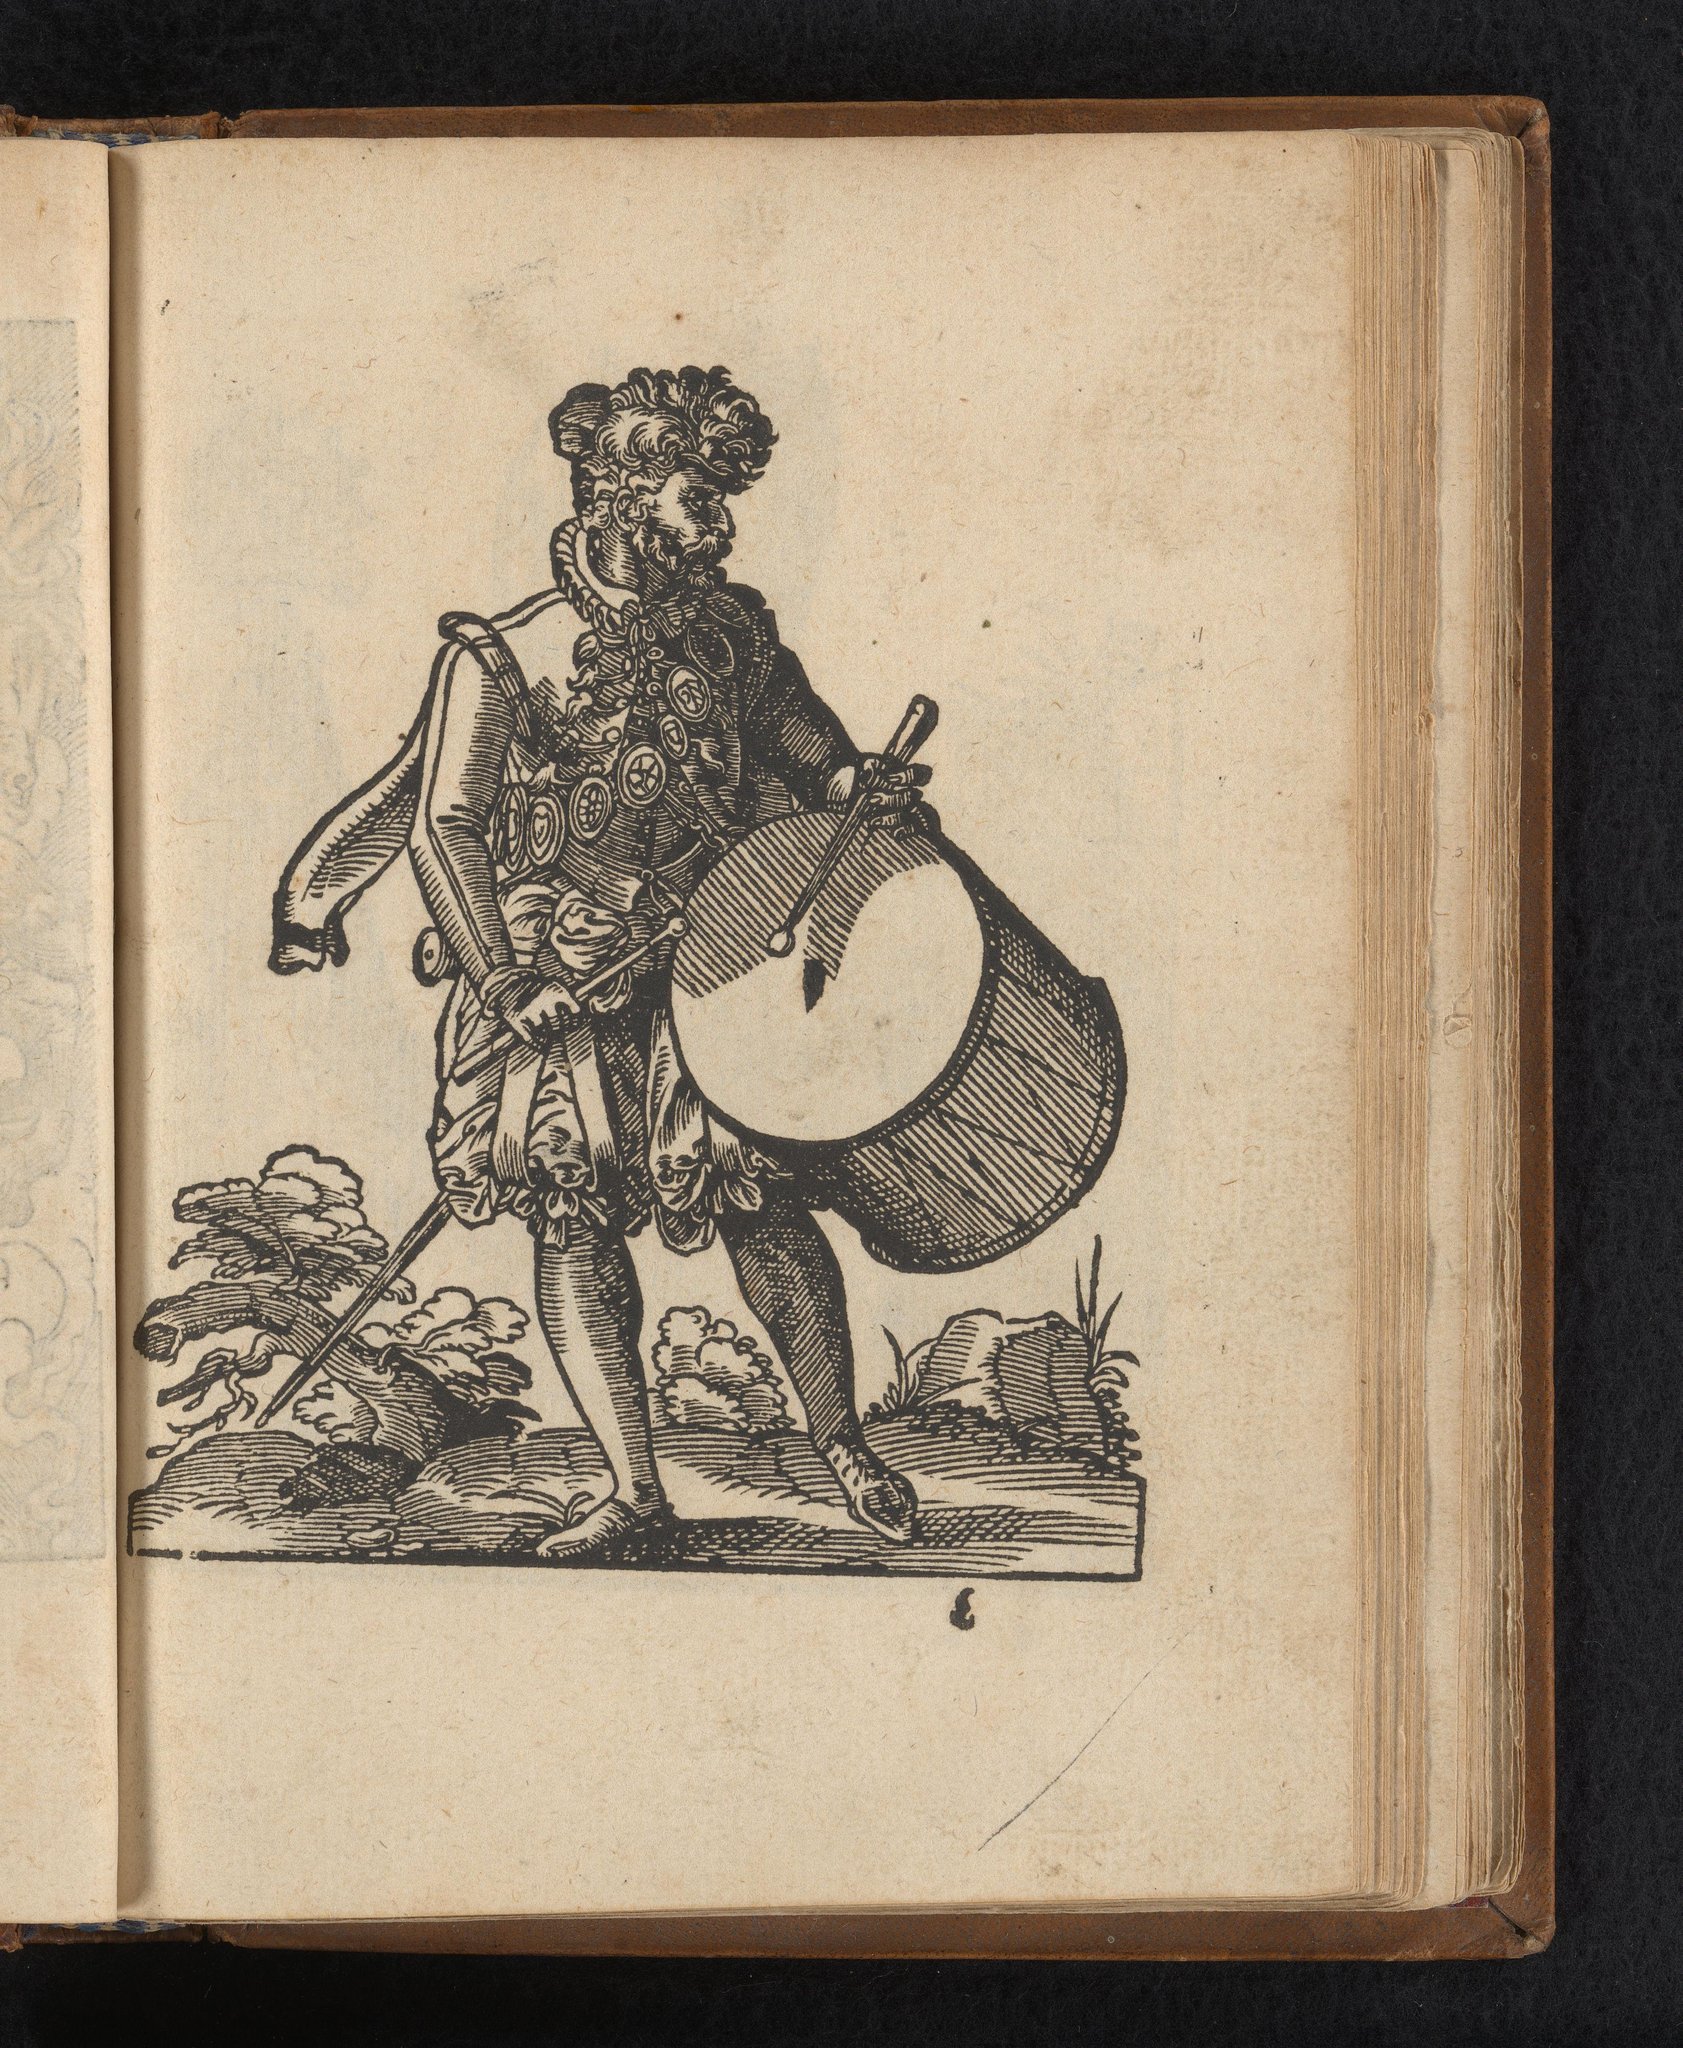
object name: print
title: Trommelaar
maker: Anonymous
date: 1578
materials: paper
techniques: woodcut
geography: nuremberg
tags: military music, drum (musical instrument)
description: Trommelaar, soldaat met trommel. Onderdeel van het modelboek Enchiridion artis pingendi, fingendi & sculpendi met 108 figuren bedoeld voor beginnende schilders, beeldhouwers en prentmakers.